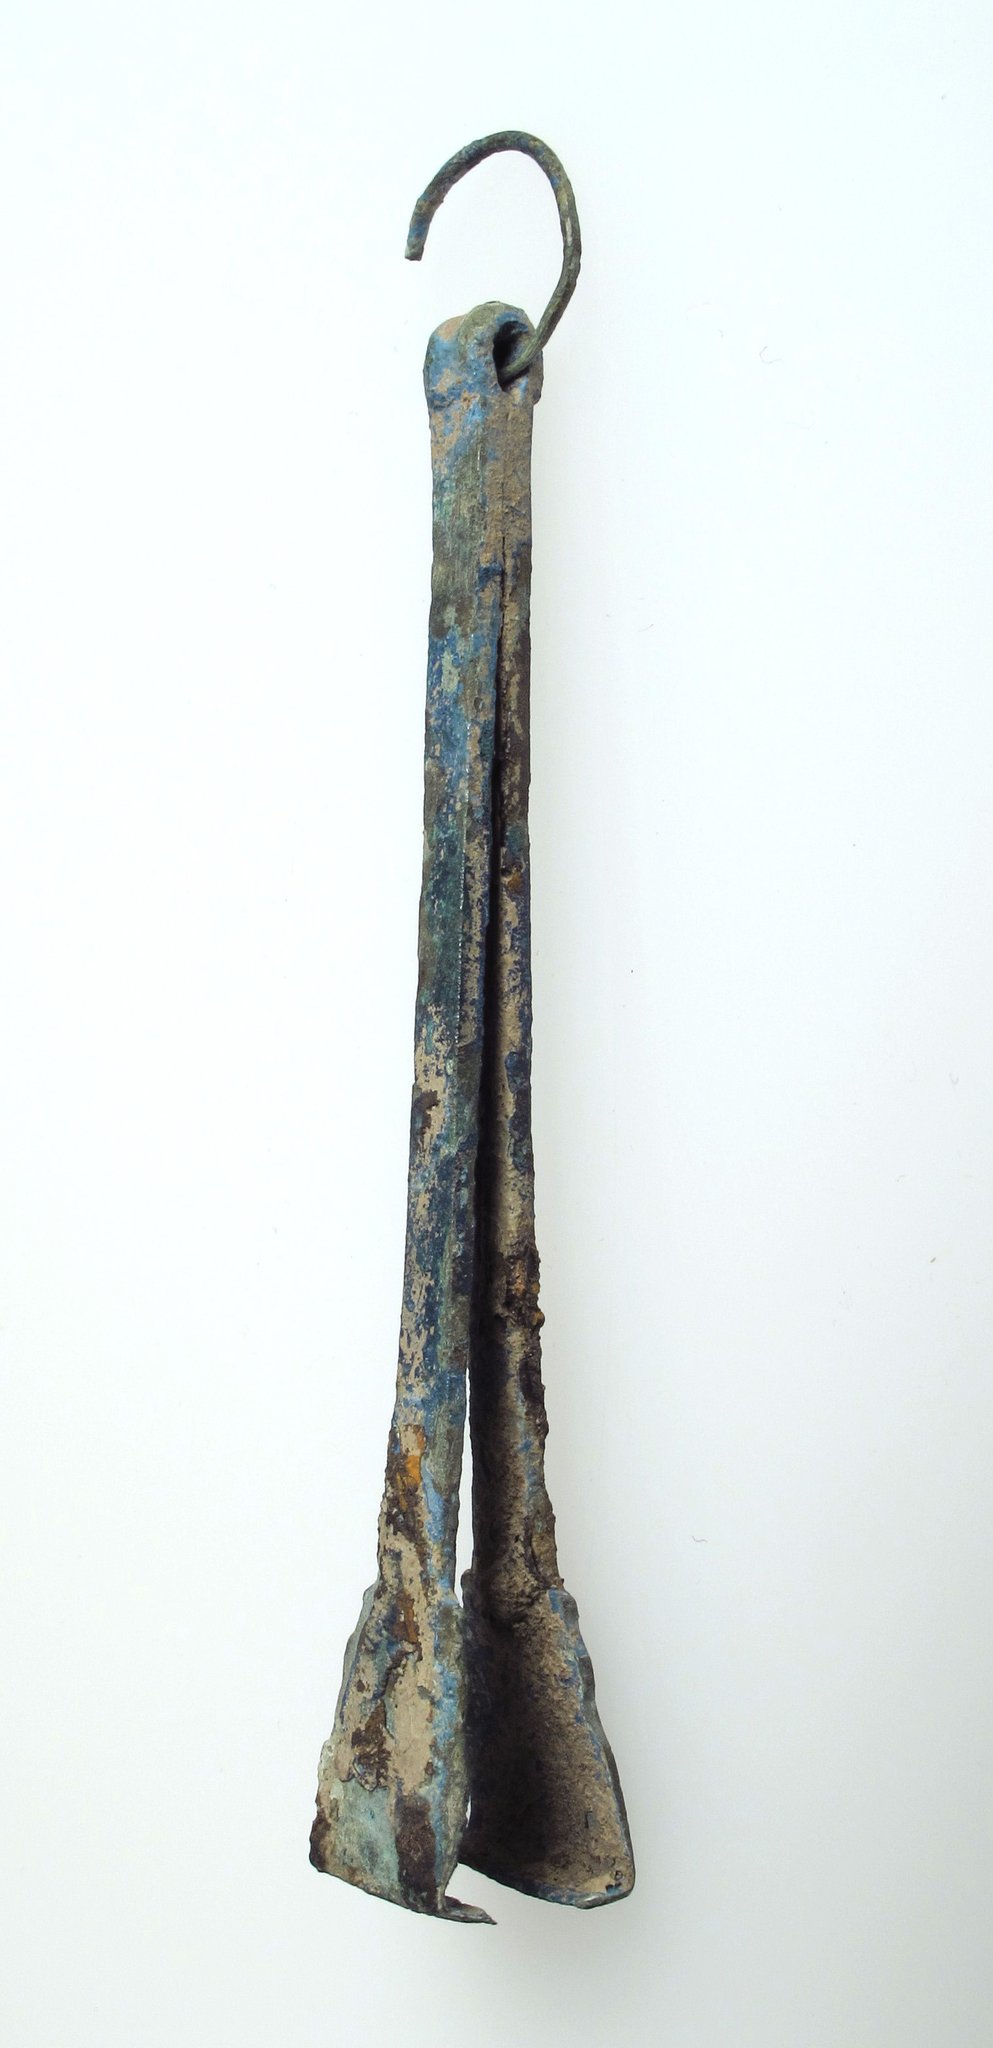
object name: tweezer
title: Tweezers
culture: frankish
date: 601-700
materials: copper alloy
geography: germany